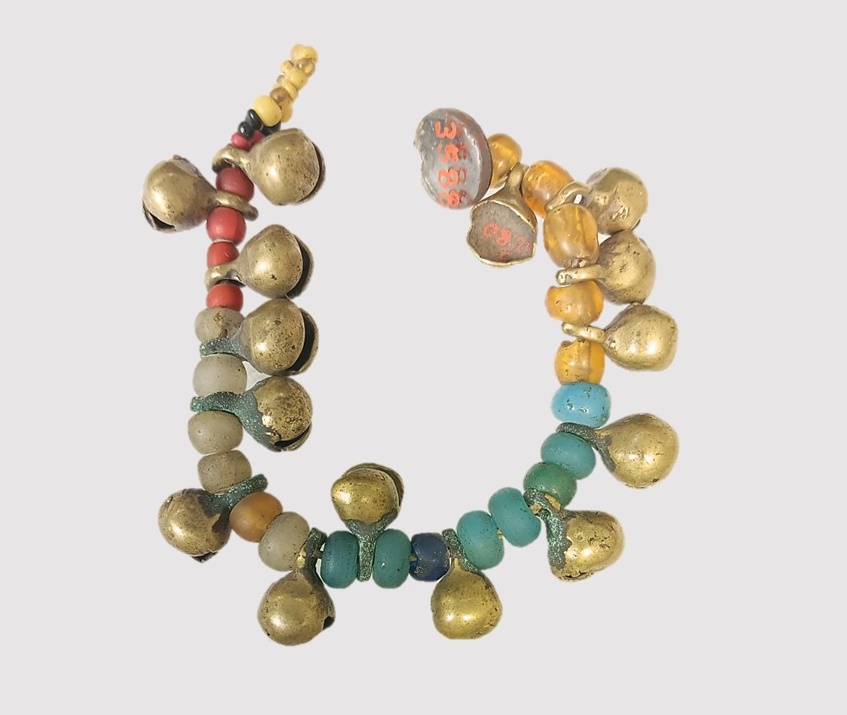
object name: bracelet rattle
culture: bornean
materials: glass, iron, rattan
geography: borneo